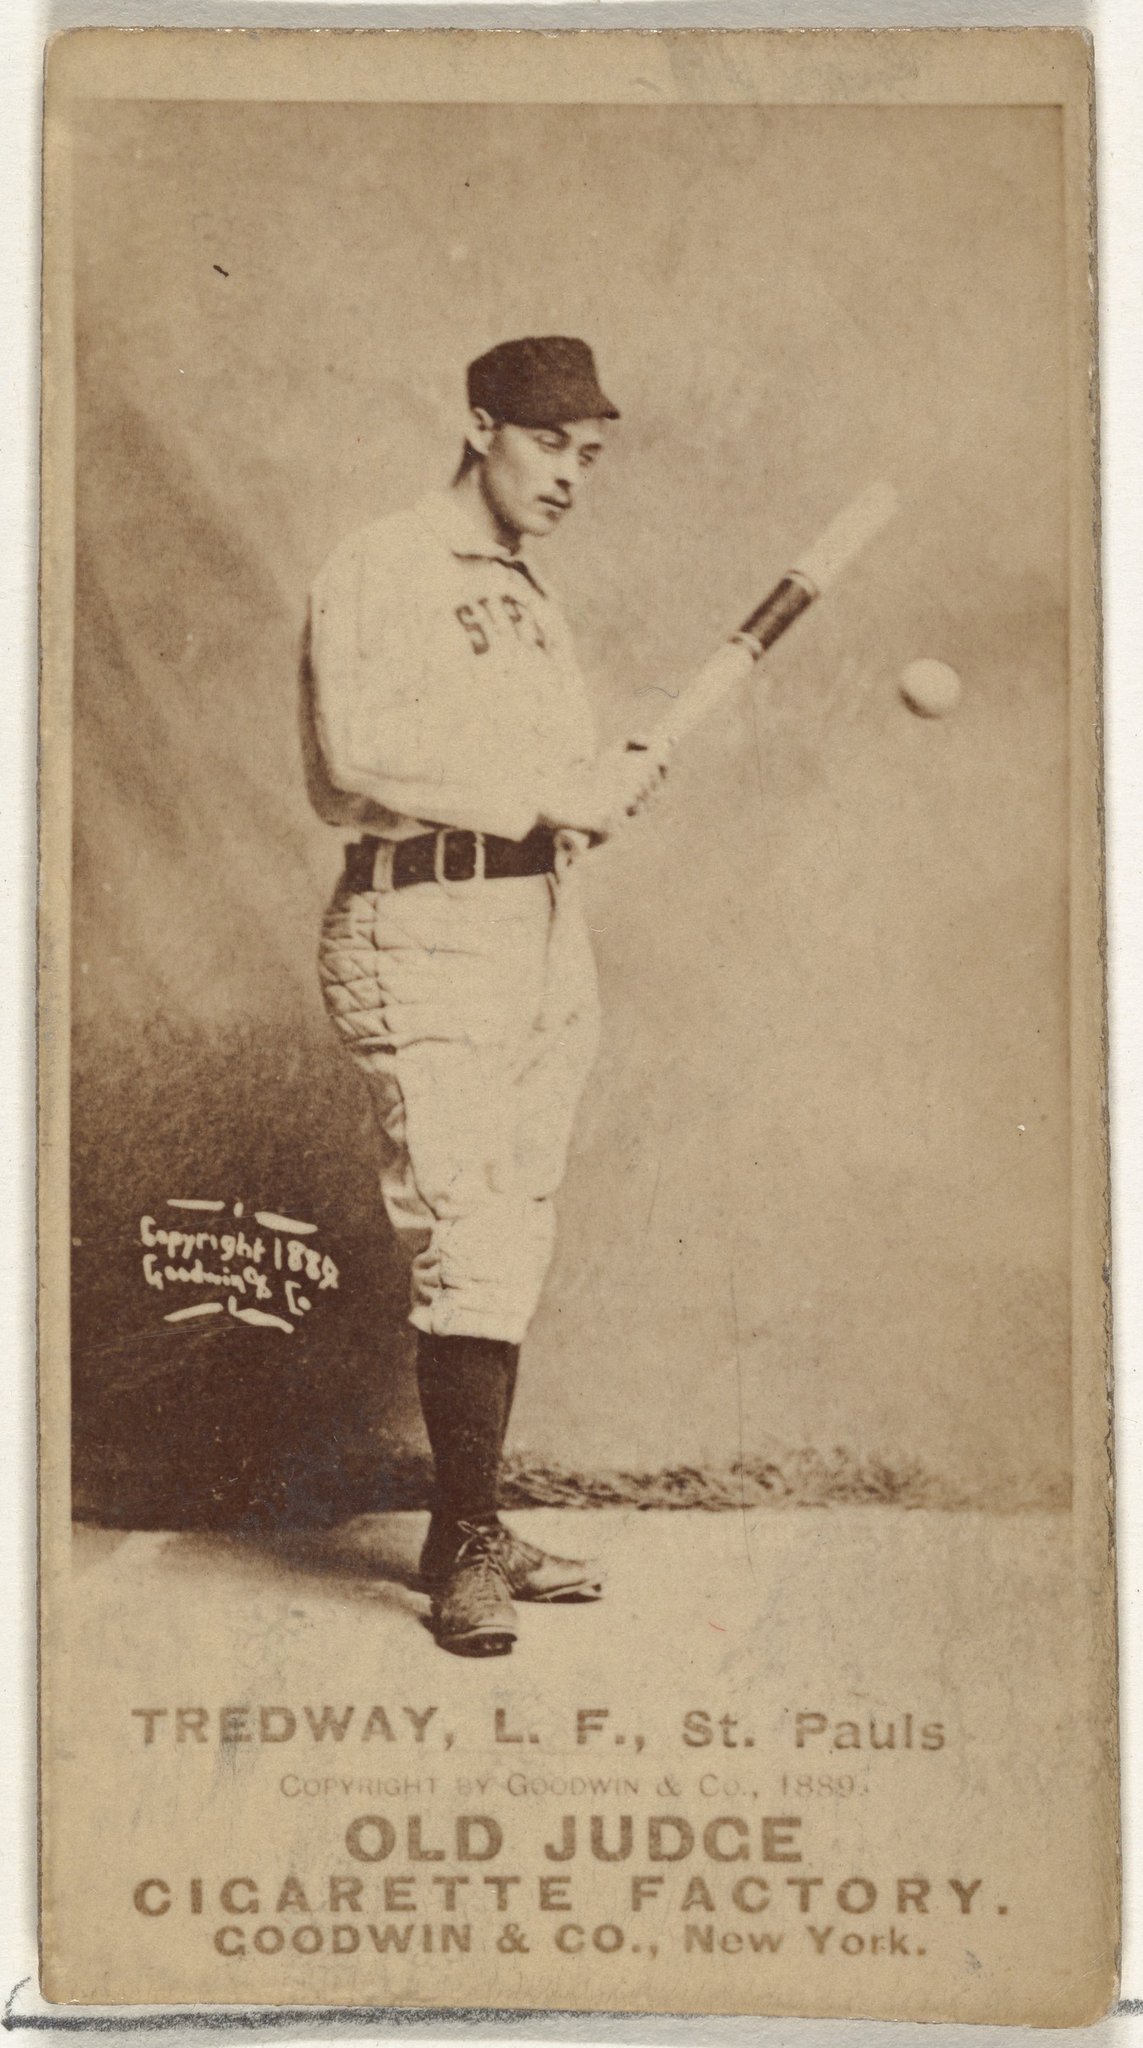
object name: baseball card, photograph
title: George B. Treadway, Left Field, St. Paul Apostles, from the Old Judge series (N172) for Old Judge Cigarettes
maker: goodwin & company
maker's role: publisher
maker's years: 1850-1950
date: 1889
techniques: albumen silver print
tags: men,portraits,baseball,athletes